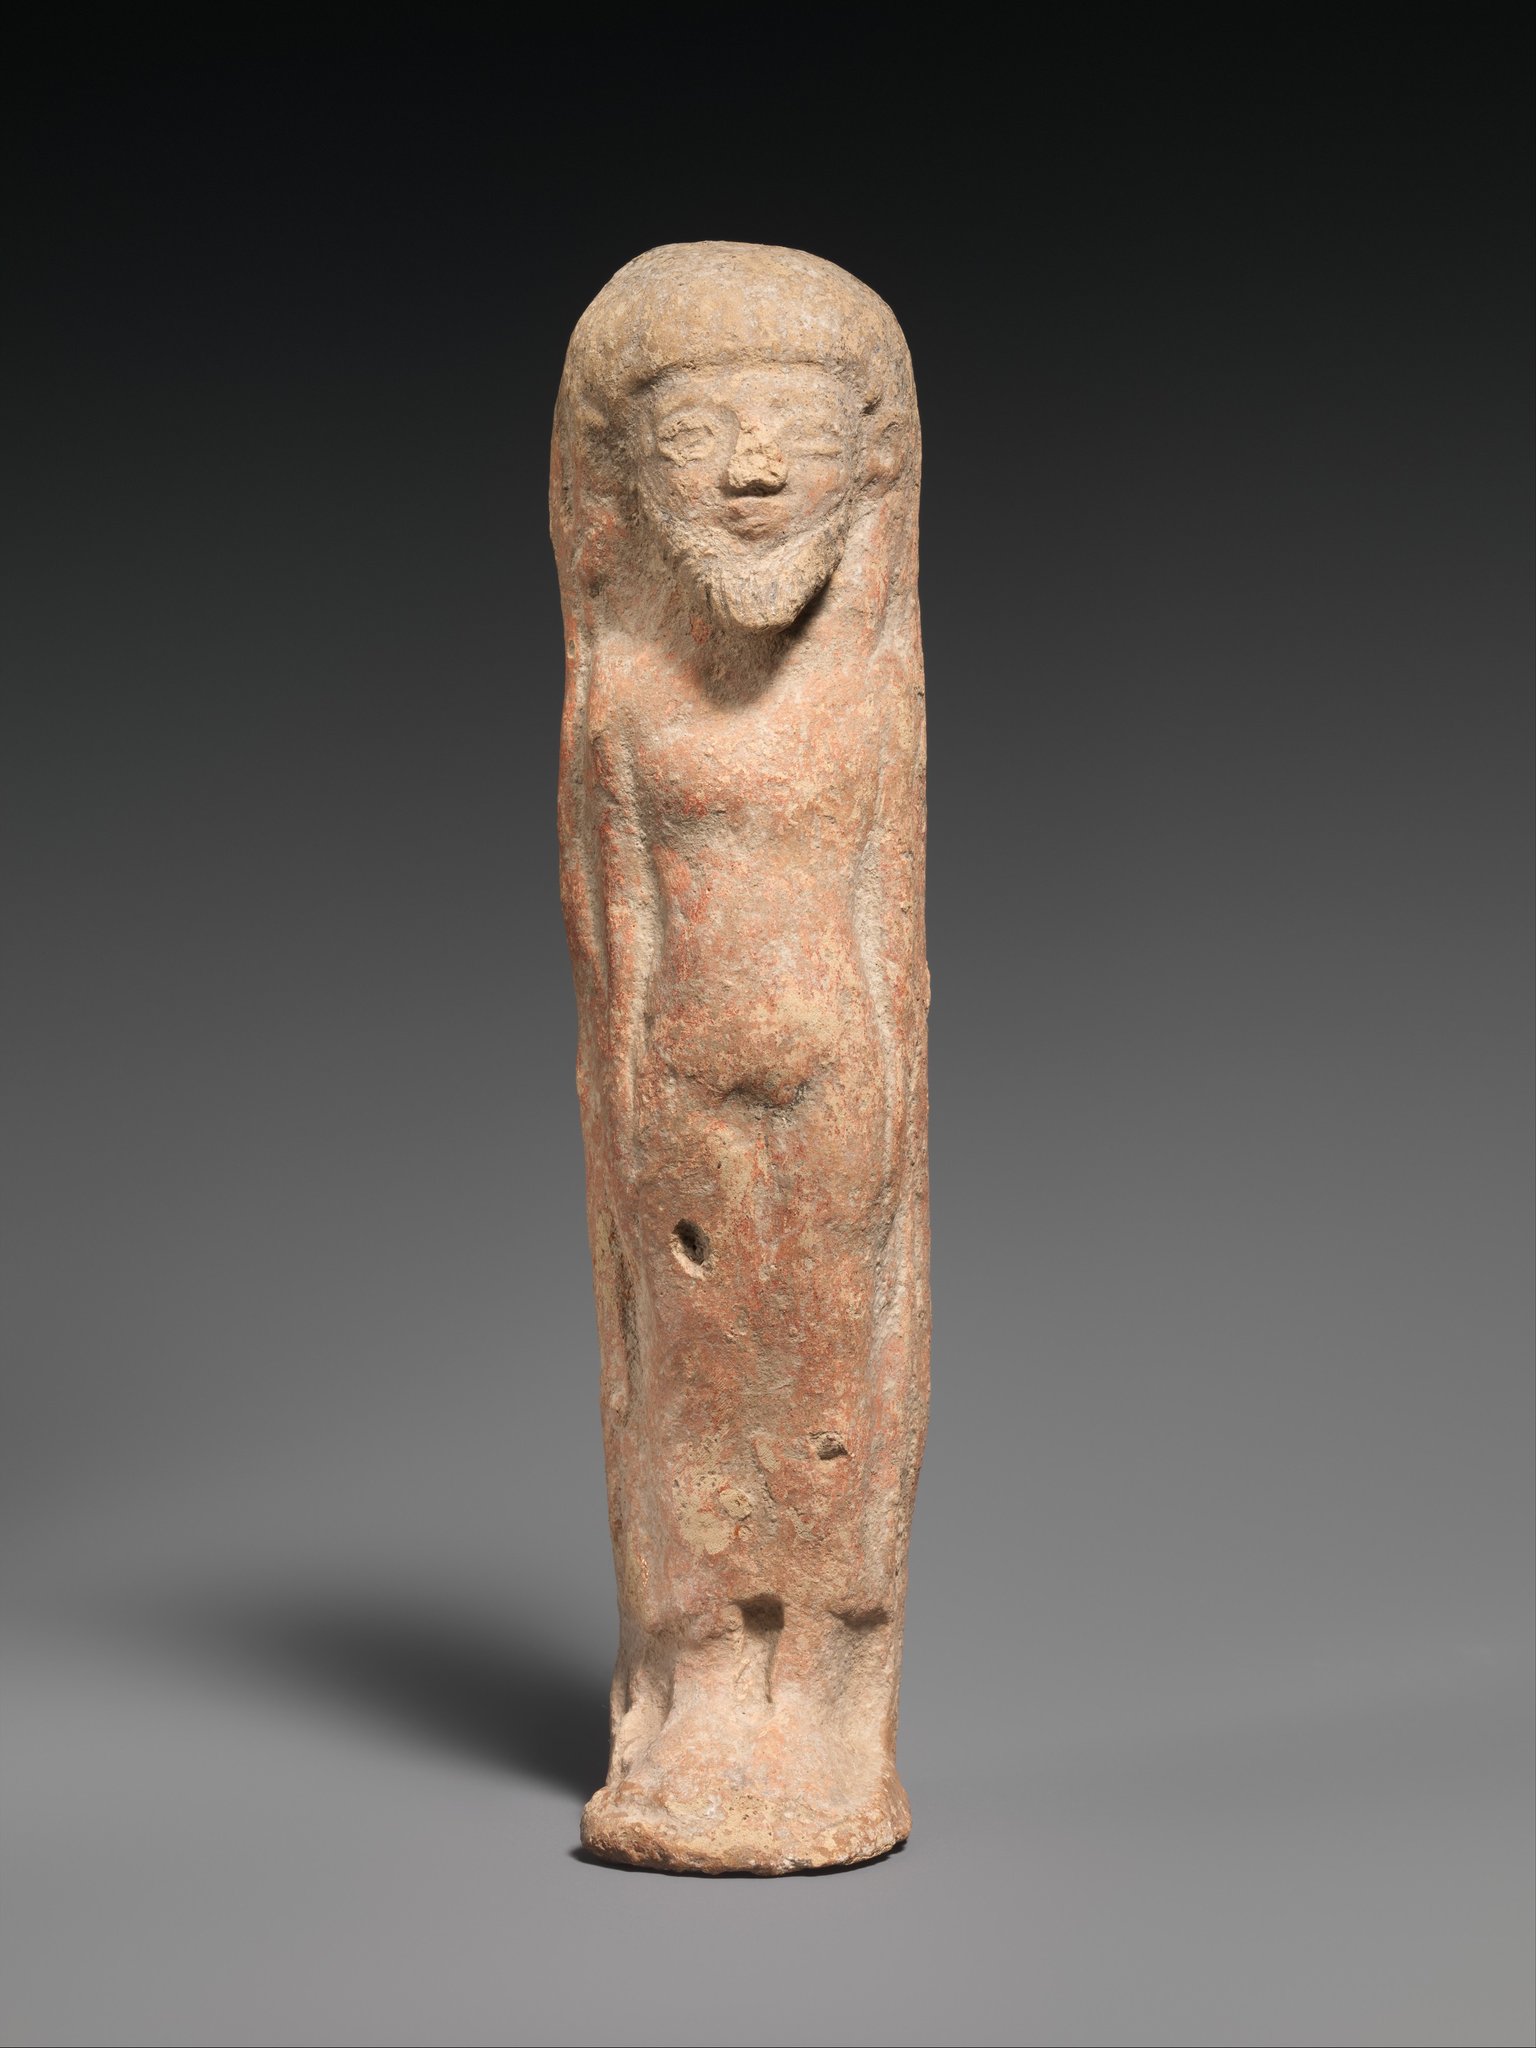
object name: statuette of a bearded woman bearded aphrodite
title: Terracotta figure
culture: cypriot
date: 600-480 BCE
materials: terracotta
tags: women